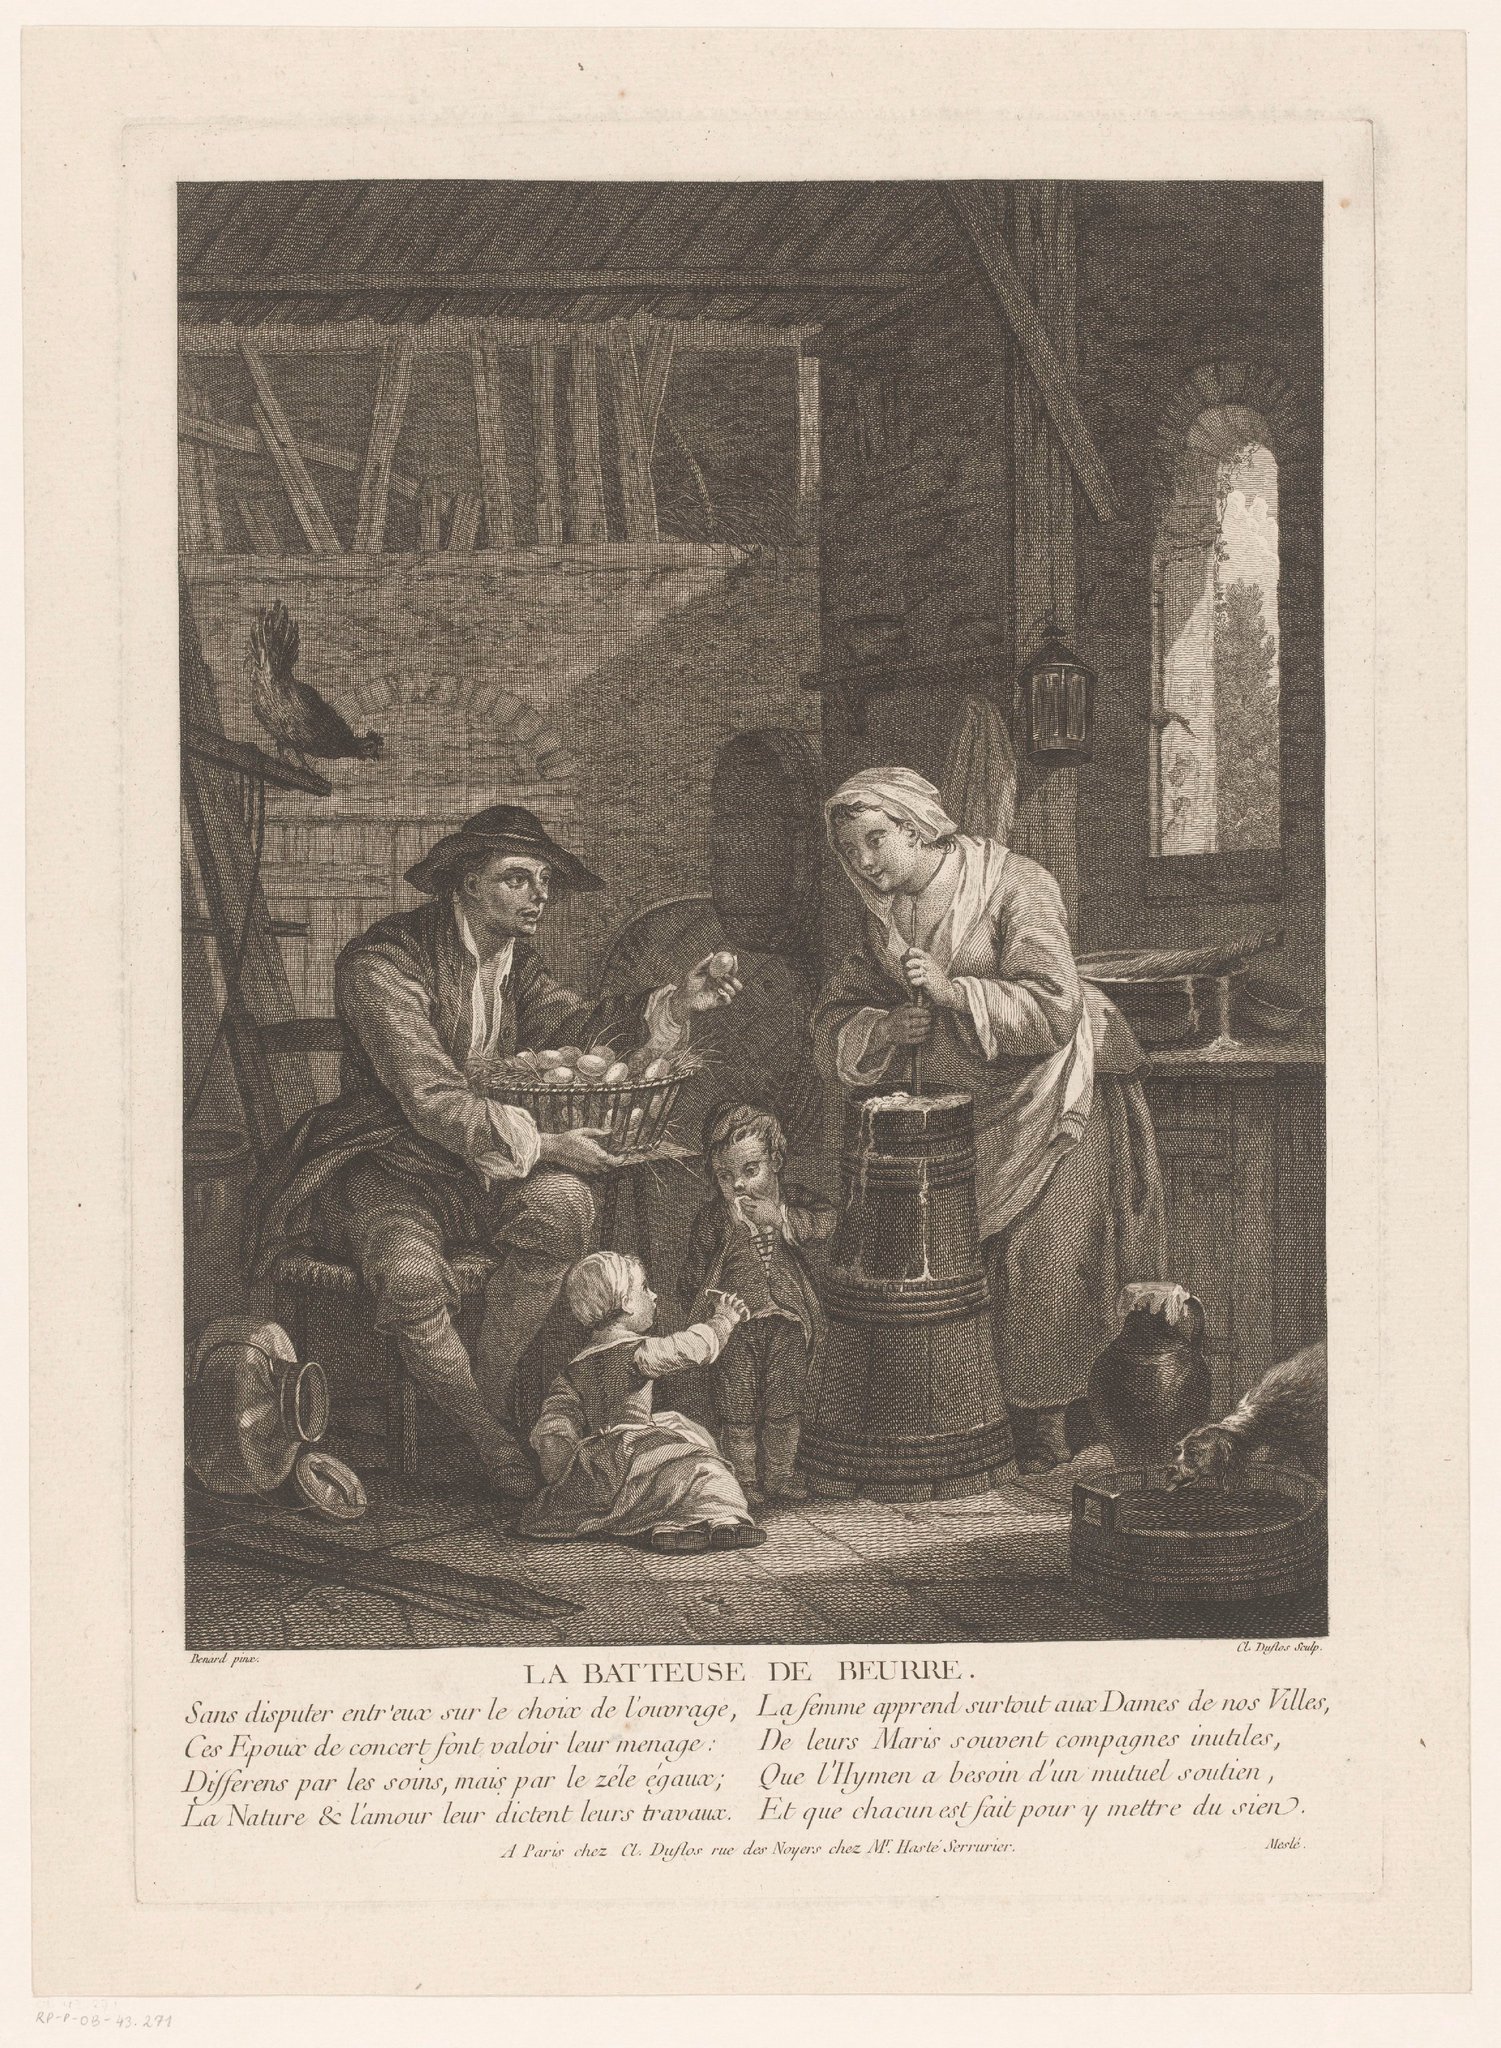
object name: print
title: Interieur met een vrouw die boter karnt en een man met eiermand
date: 1710-1786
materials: paper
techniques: engraving, etching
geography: france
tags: butter, stirring, to cool food before eating, interior of the house, eggs, egg-dishes, churning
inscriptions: collector's mark: Lugt 2228